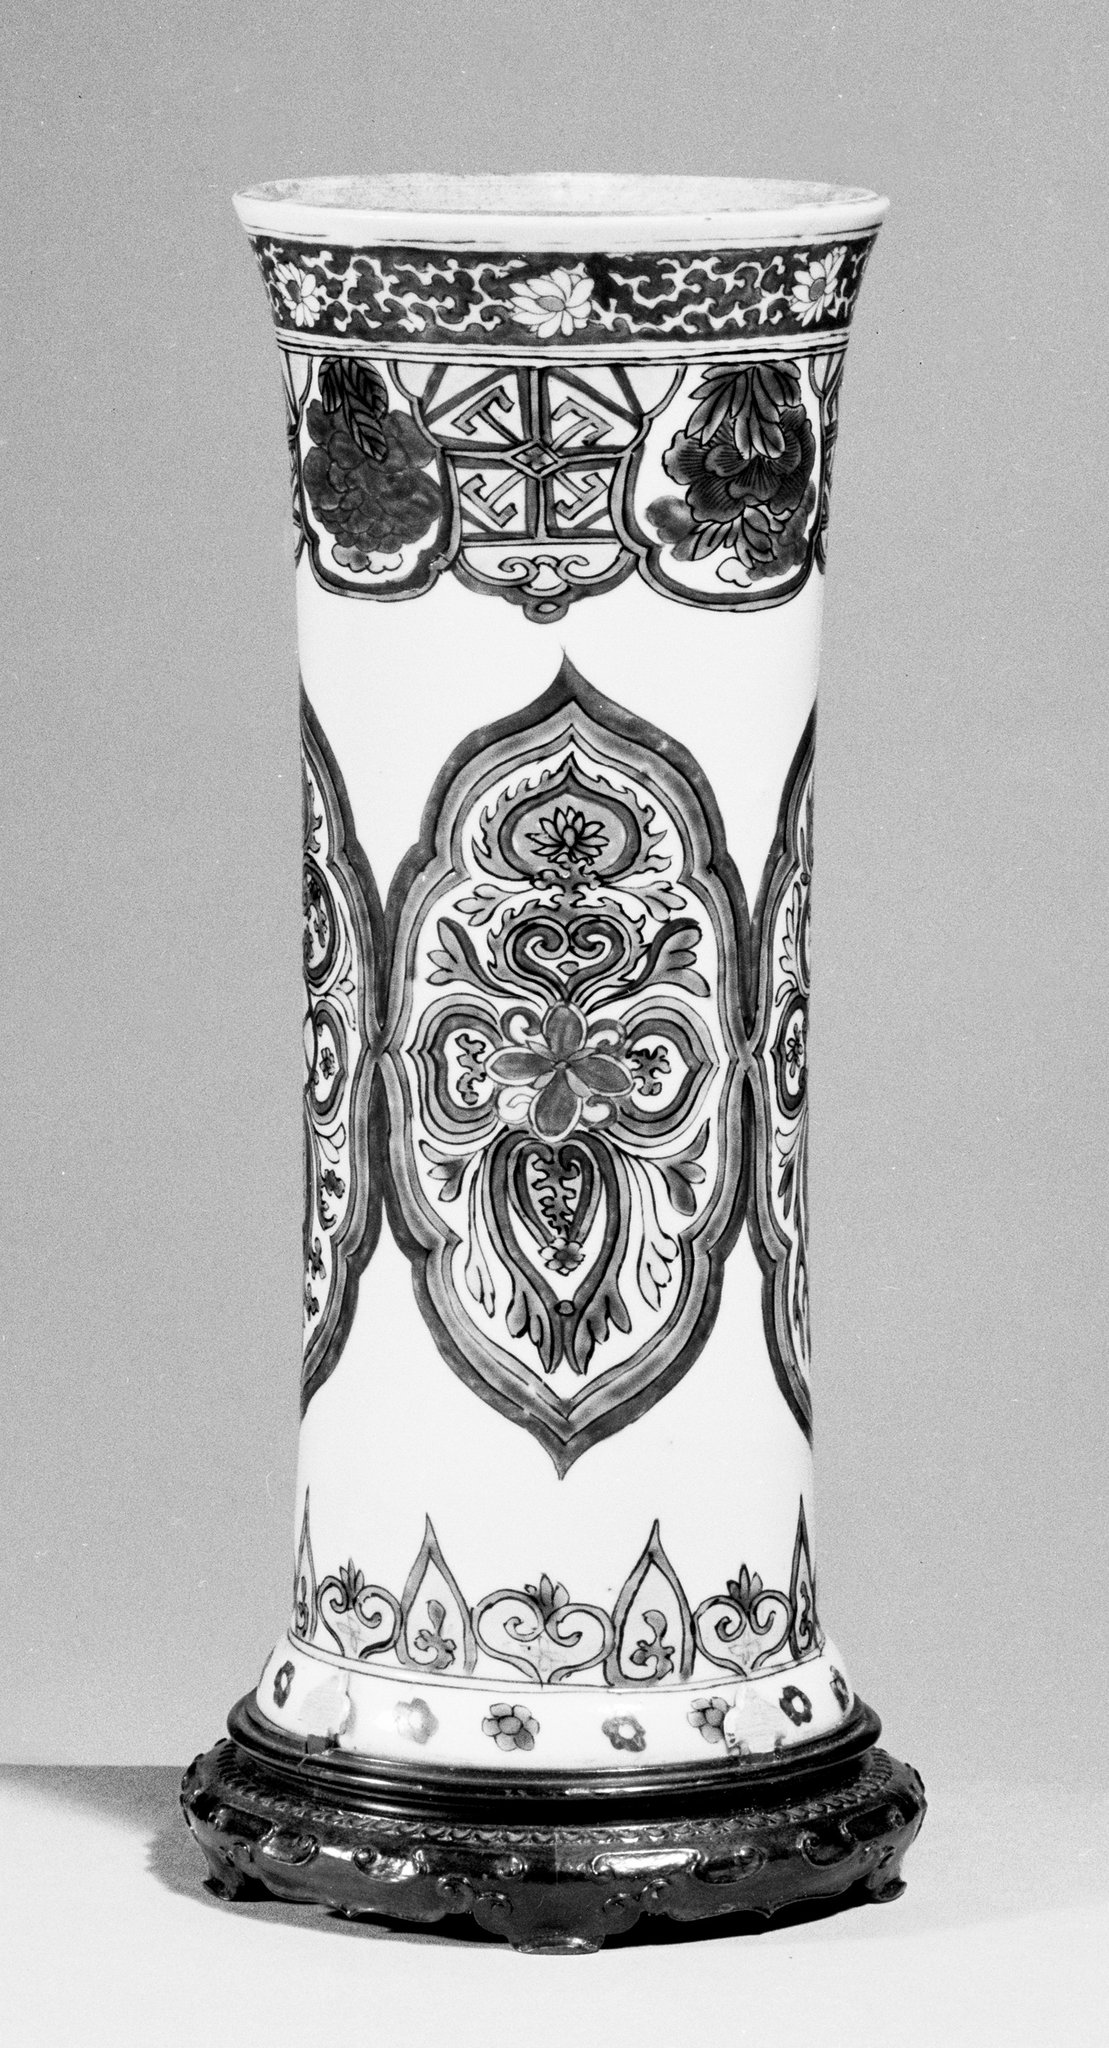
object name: vase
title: Vase (one of a pair)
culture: chinese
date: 1667-1733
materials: enamel, porcelain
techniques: overglaze, painting, polychrome